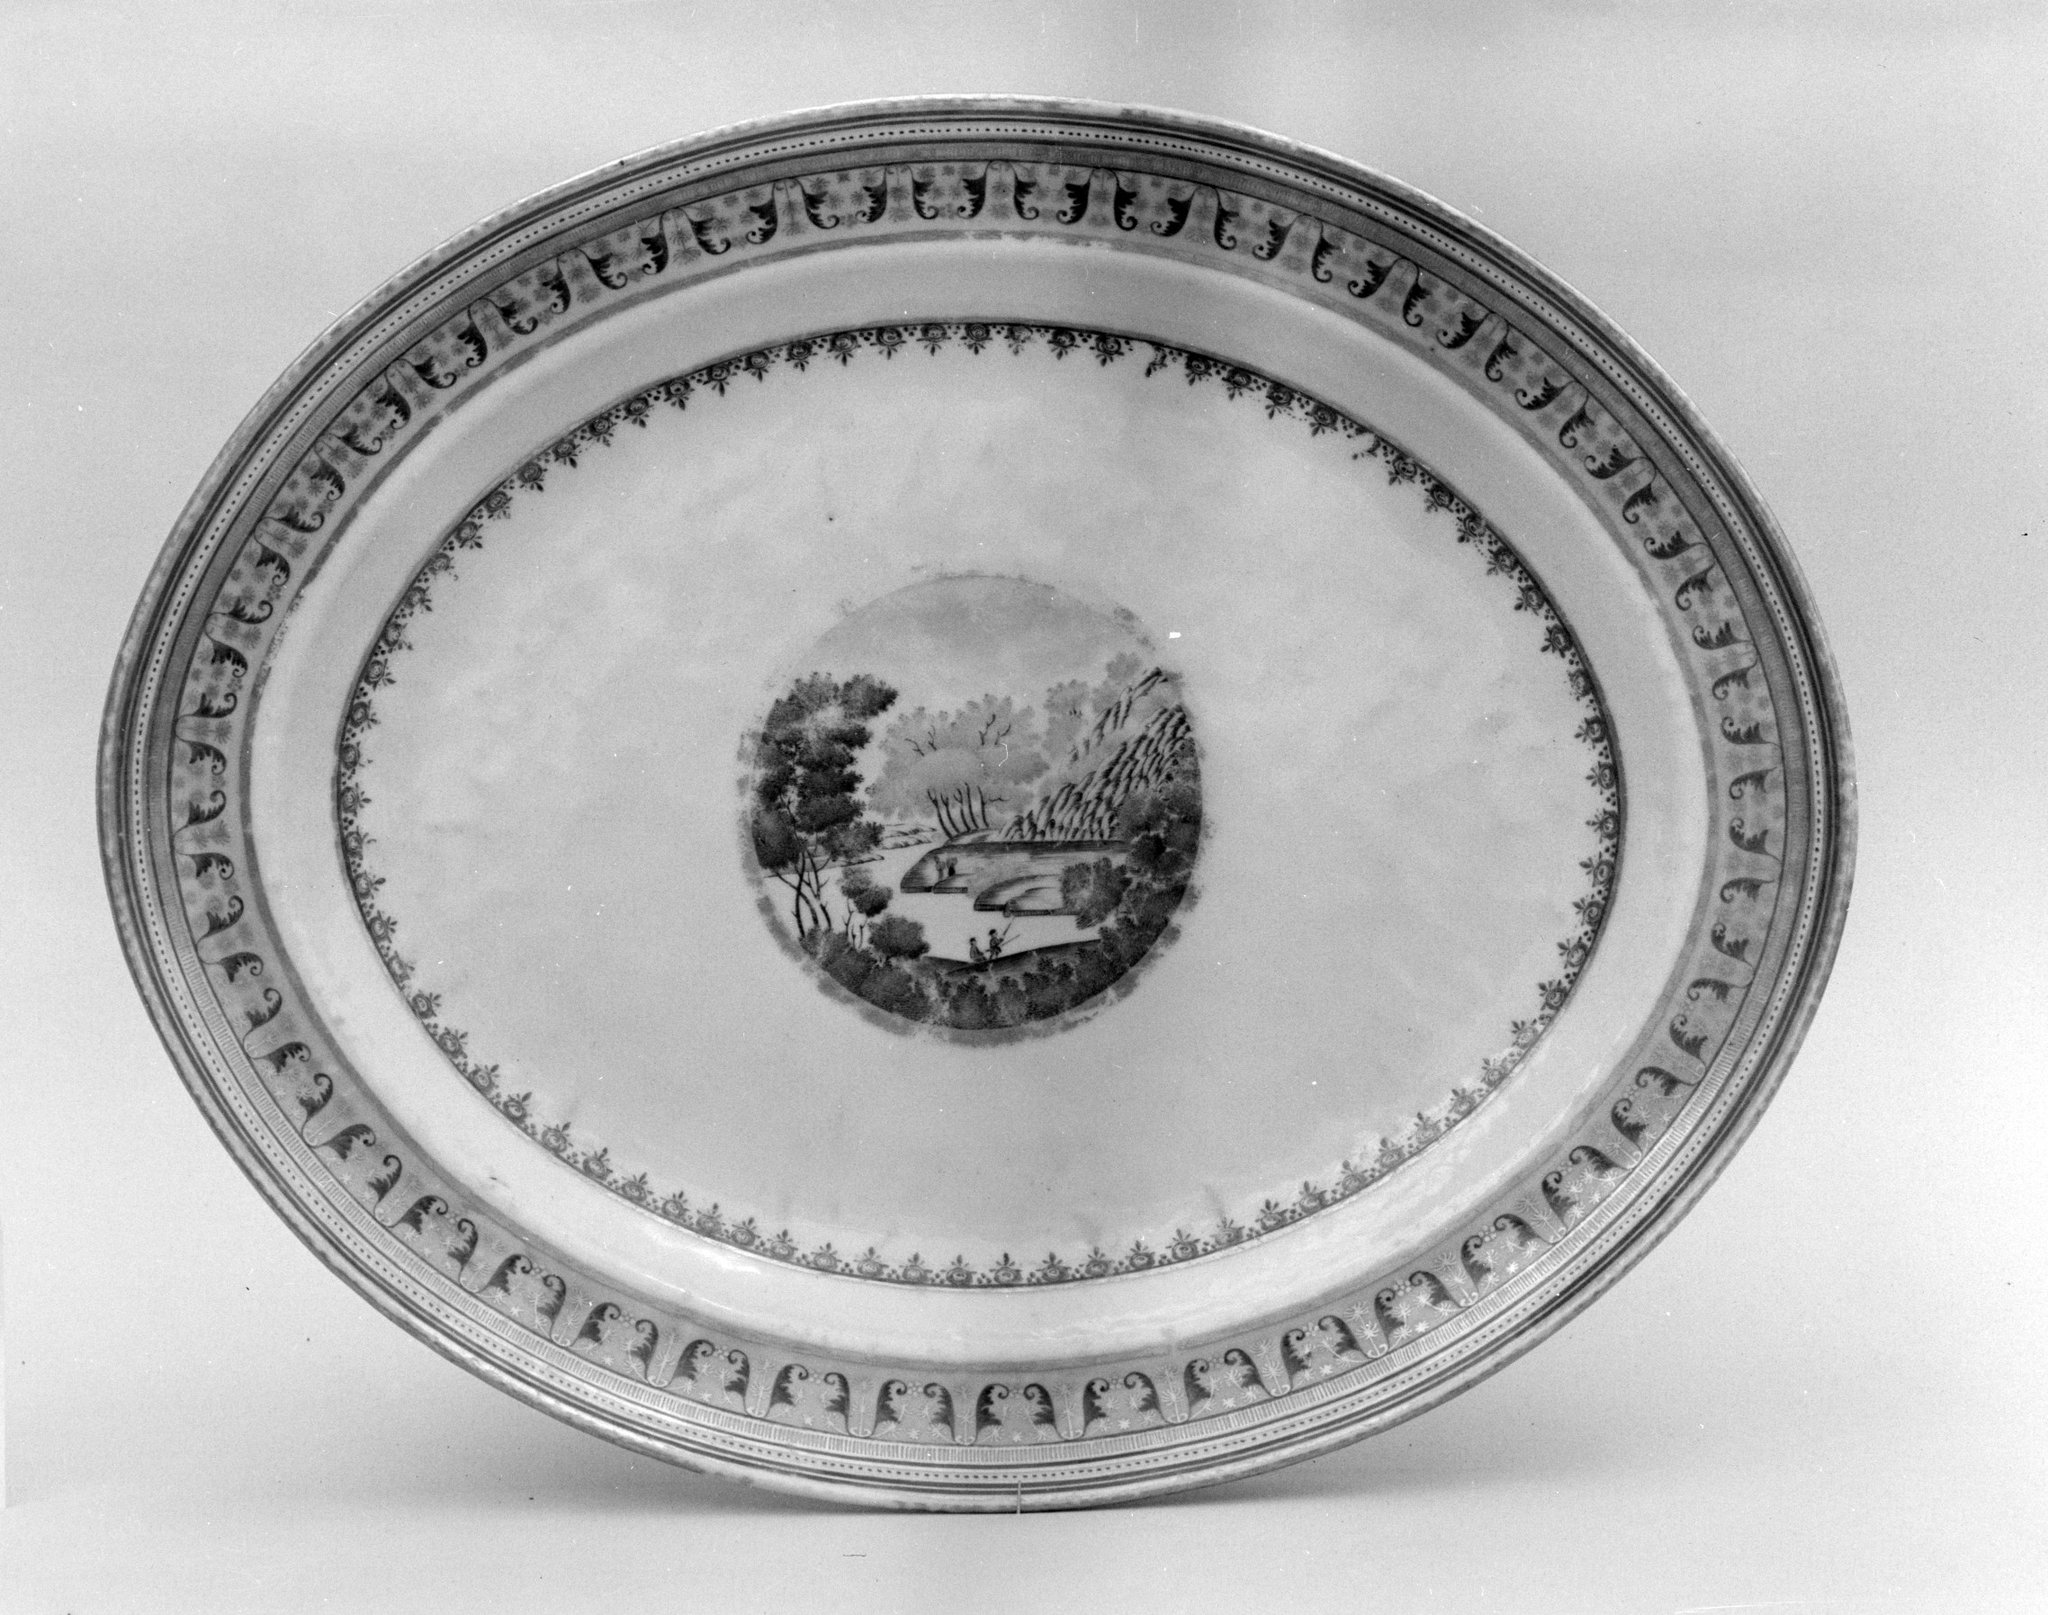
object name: platter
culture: chinese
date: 1800-1830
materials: porcelain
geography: china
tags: landscapes